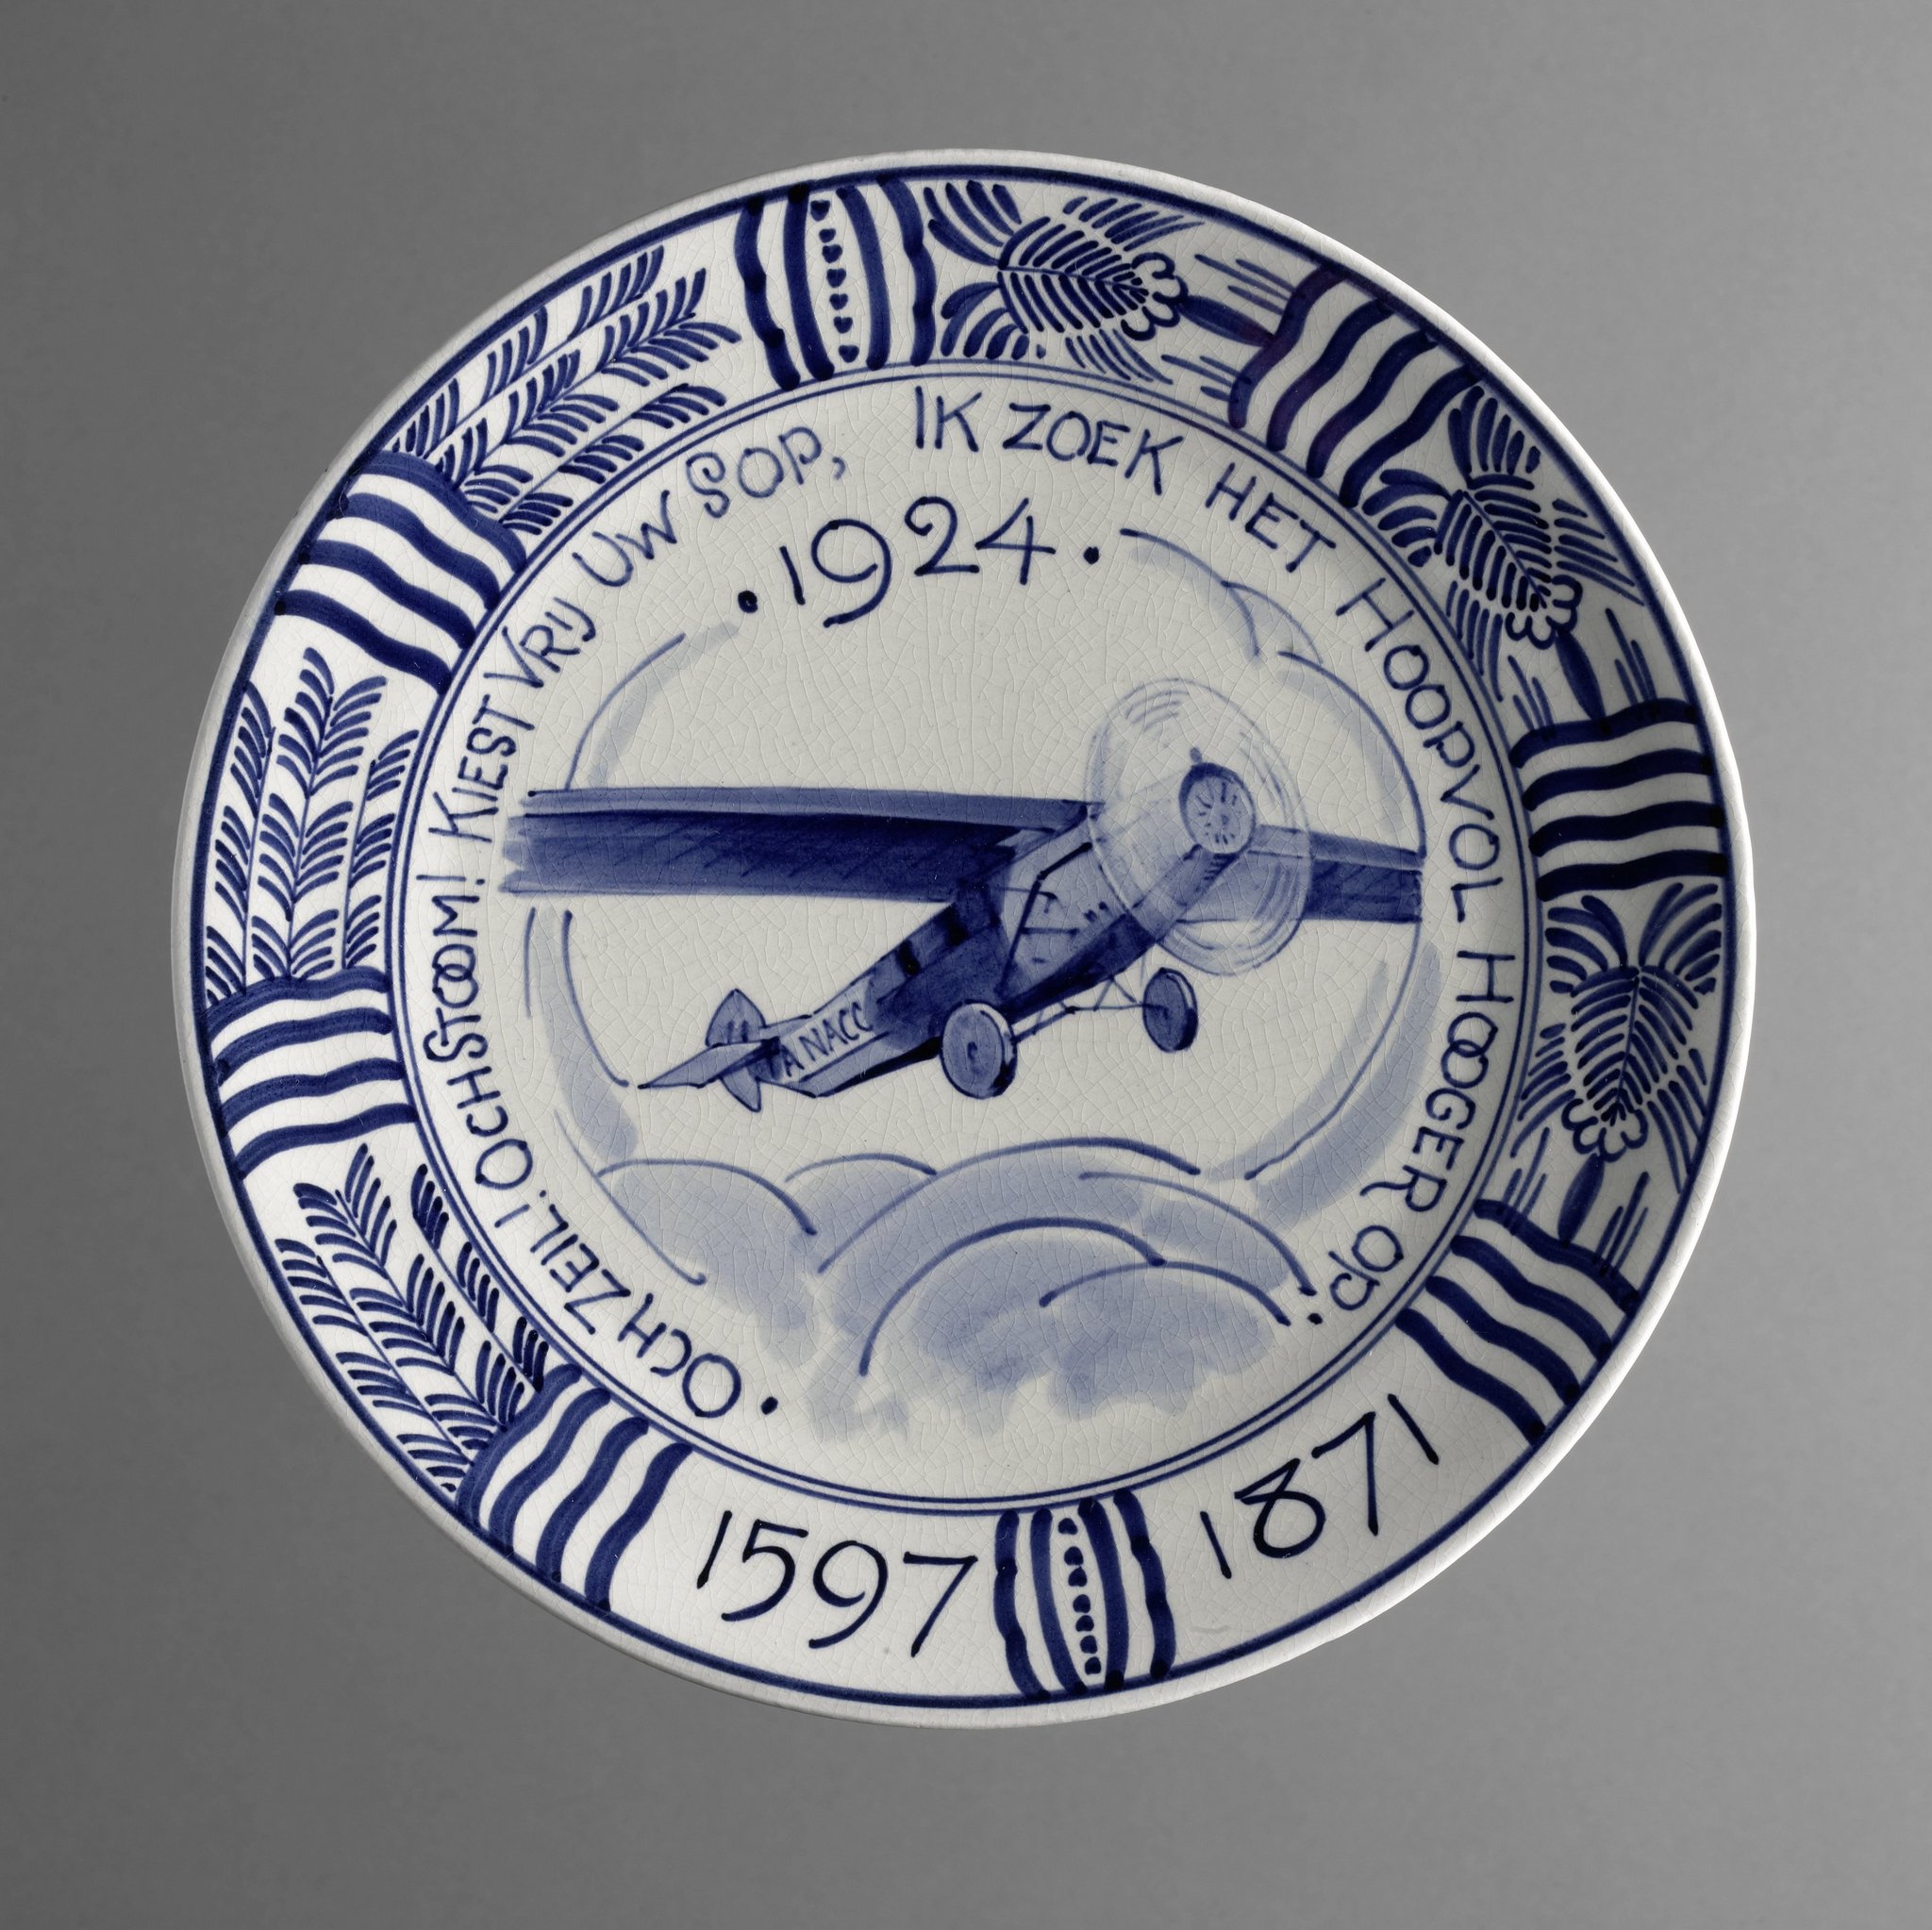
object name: herinneringsbord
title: Bord ter herinnering aan de eerste vlucht door de KLM van Amsterdam naar Batavia op 24 november 1924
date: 1925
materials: earthenware, glaze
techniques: painted, vitrification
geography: delft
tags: the hague, aircraft, aeroplane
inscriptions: date: ‘1924 1871 1597’, factory mark: ‘JT Delft’, check stamp: ‘XII’, title: ‘OCH ZEIL! OCH STOOM! KIEST VRIJ UW SOP, IK ZOEK HET HOOPVOL HOOGER OP’, mark: ‘AV JT 41 AU’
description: Bord, blauw geschilderd met afbeelding van een vliegtuig. Ter herinnering aan de eerste vlucht door de KLM van Amsterdam naar Batavia op 24 november 1924. Het vliegtuig is een Fokker F-VII. De bemanning bestond uit Jan van der Hoop, Hendrik Weerden Poelman en Pieter van den Broeke. Met opschrift. Achterzijde voorzien van twee gaatjes en ijzerdraad om bord op te hangen. Gemerkt.